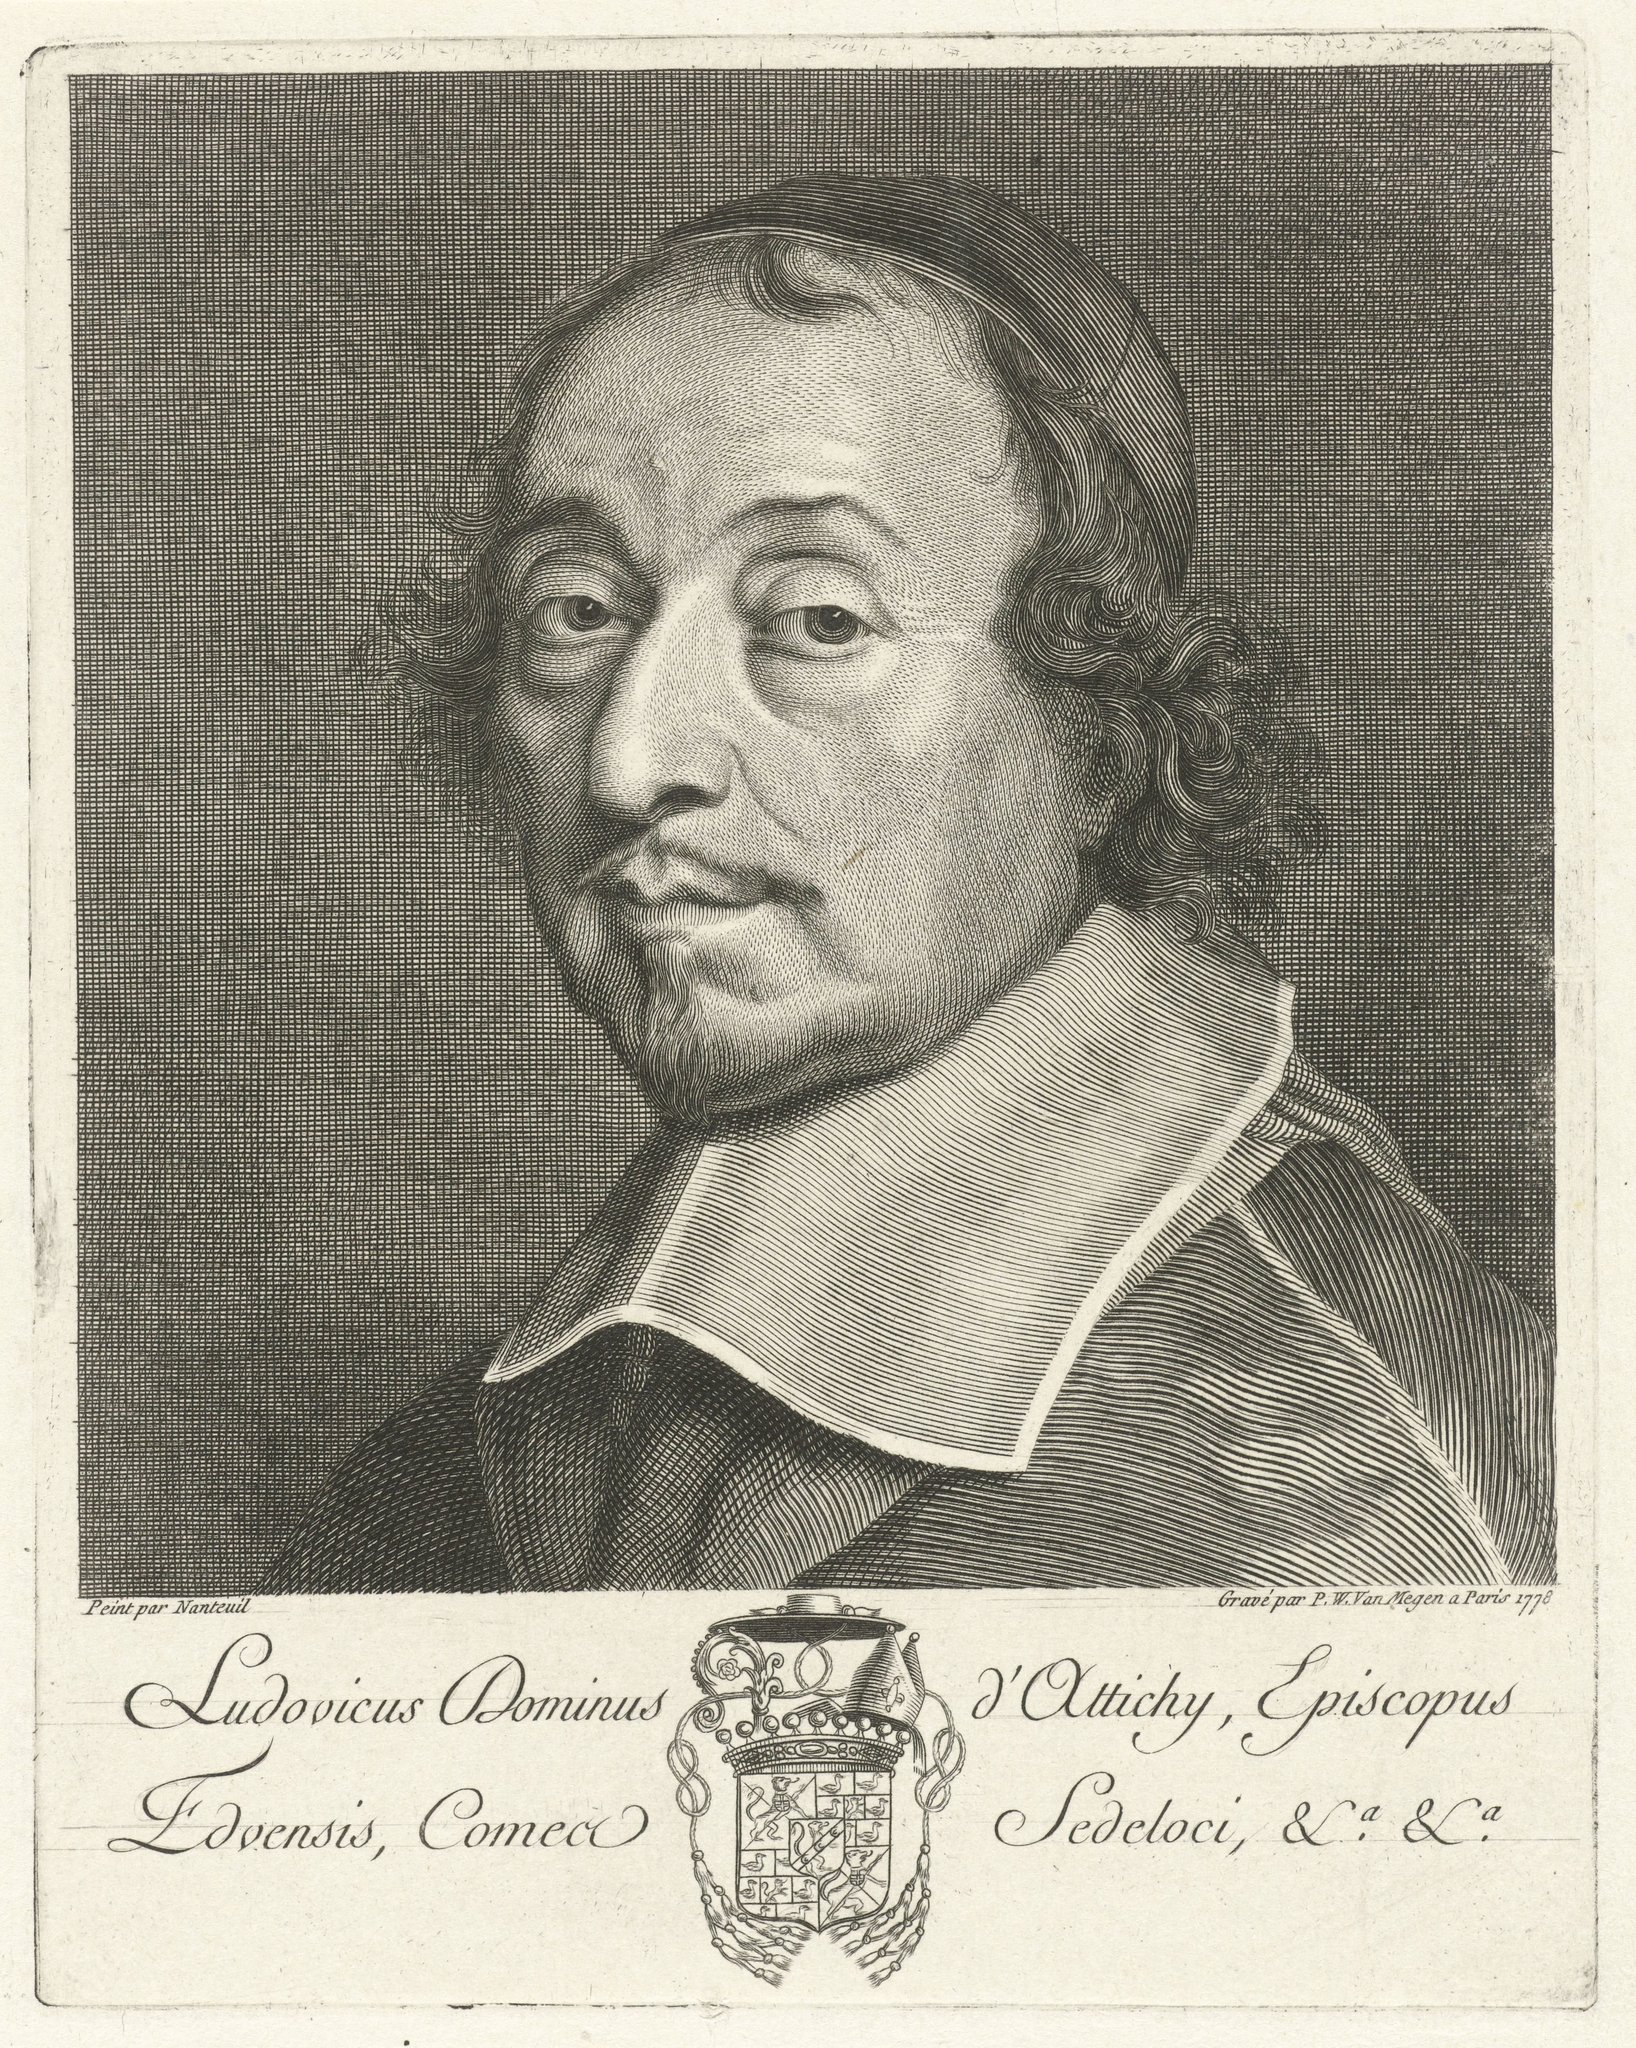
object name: print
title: Portret van Louis Doni d'Attichy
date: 1778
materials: paper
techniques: engraving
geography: paris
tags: louis doni d' attichy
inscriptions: collector's mark: Lugt 240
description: Portret van Louis Doni d'Attichy, bisschop van Riez en Autun. Middenonder in de marge zijn wapen.